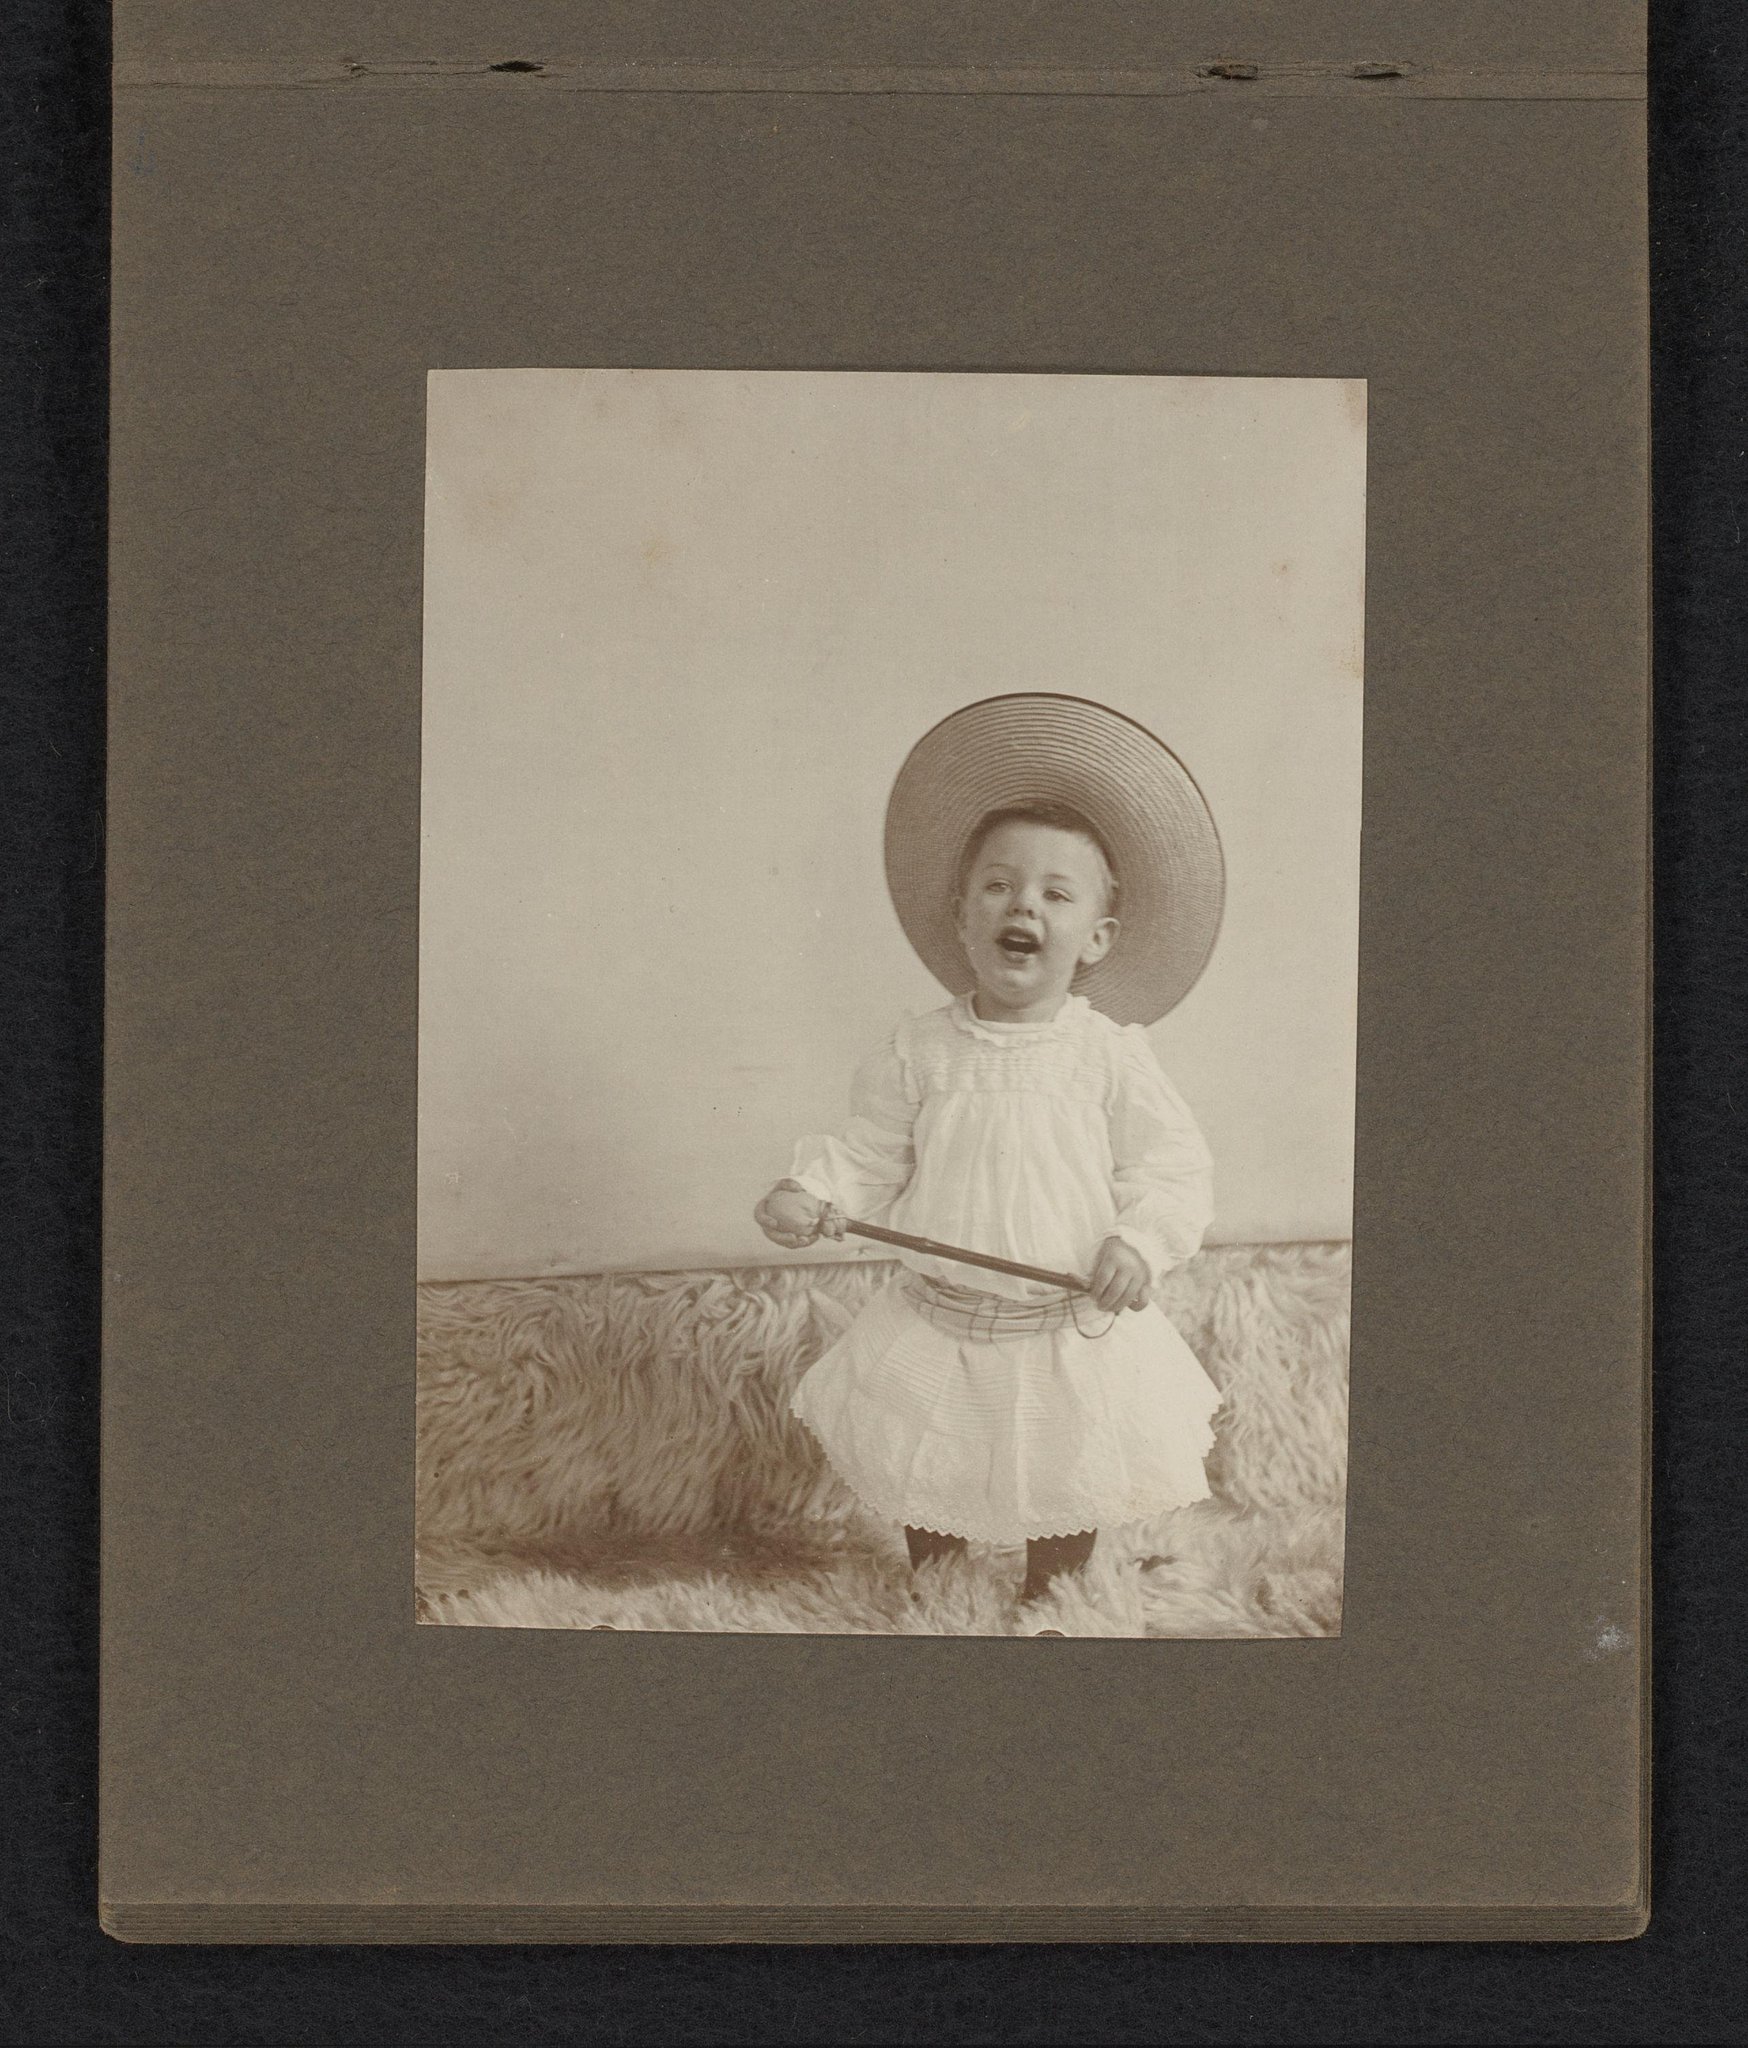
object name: album leaf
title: Carel van den Berg als peuter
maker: hendrik herman van den berg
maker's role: amateurfotograaf, jurist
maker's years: 1875-1944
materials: paper, cardboard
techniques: gelatin silver print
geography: amsterdam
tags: amsterdam, carel frederik van den berg (cay), toddler (male)